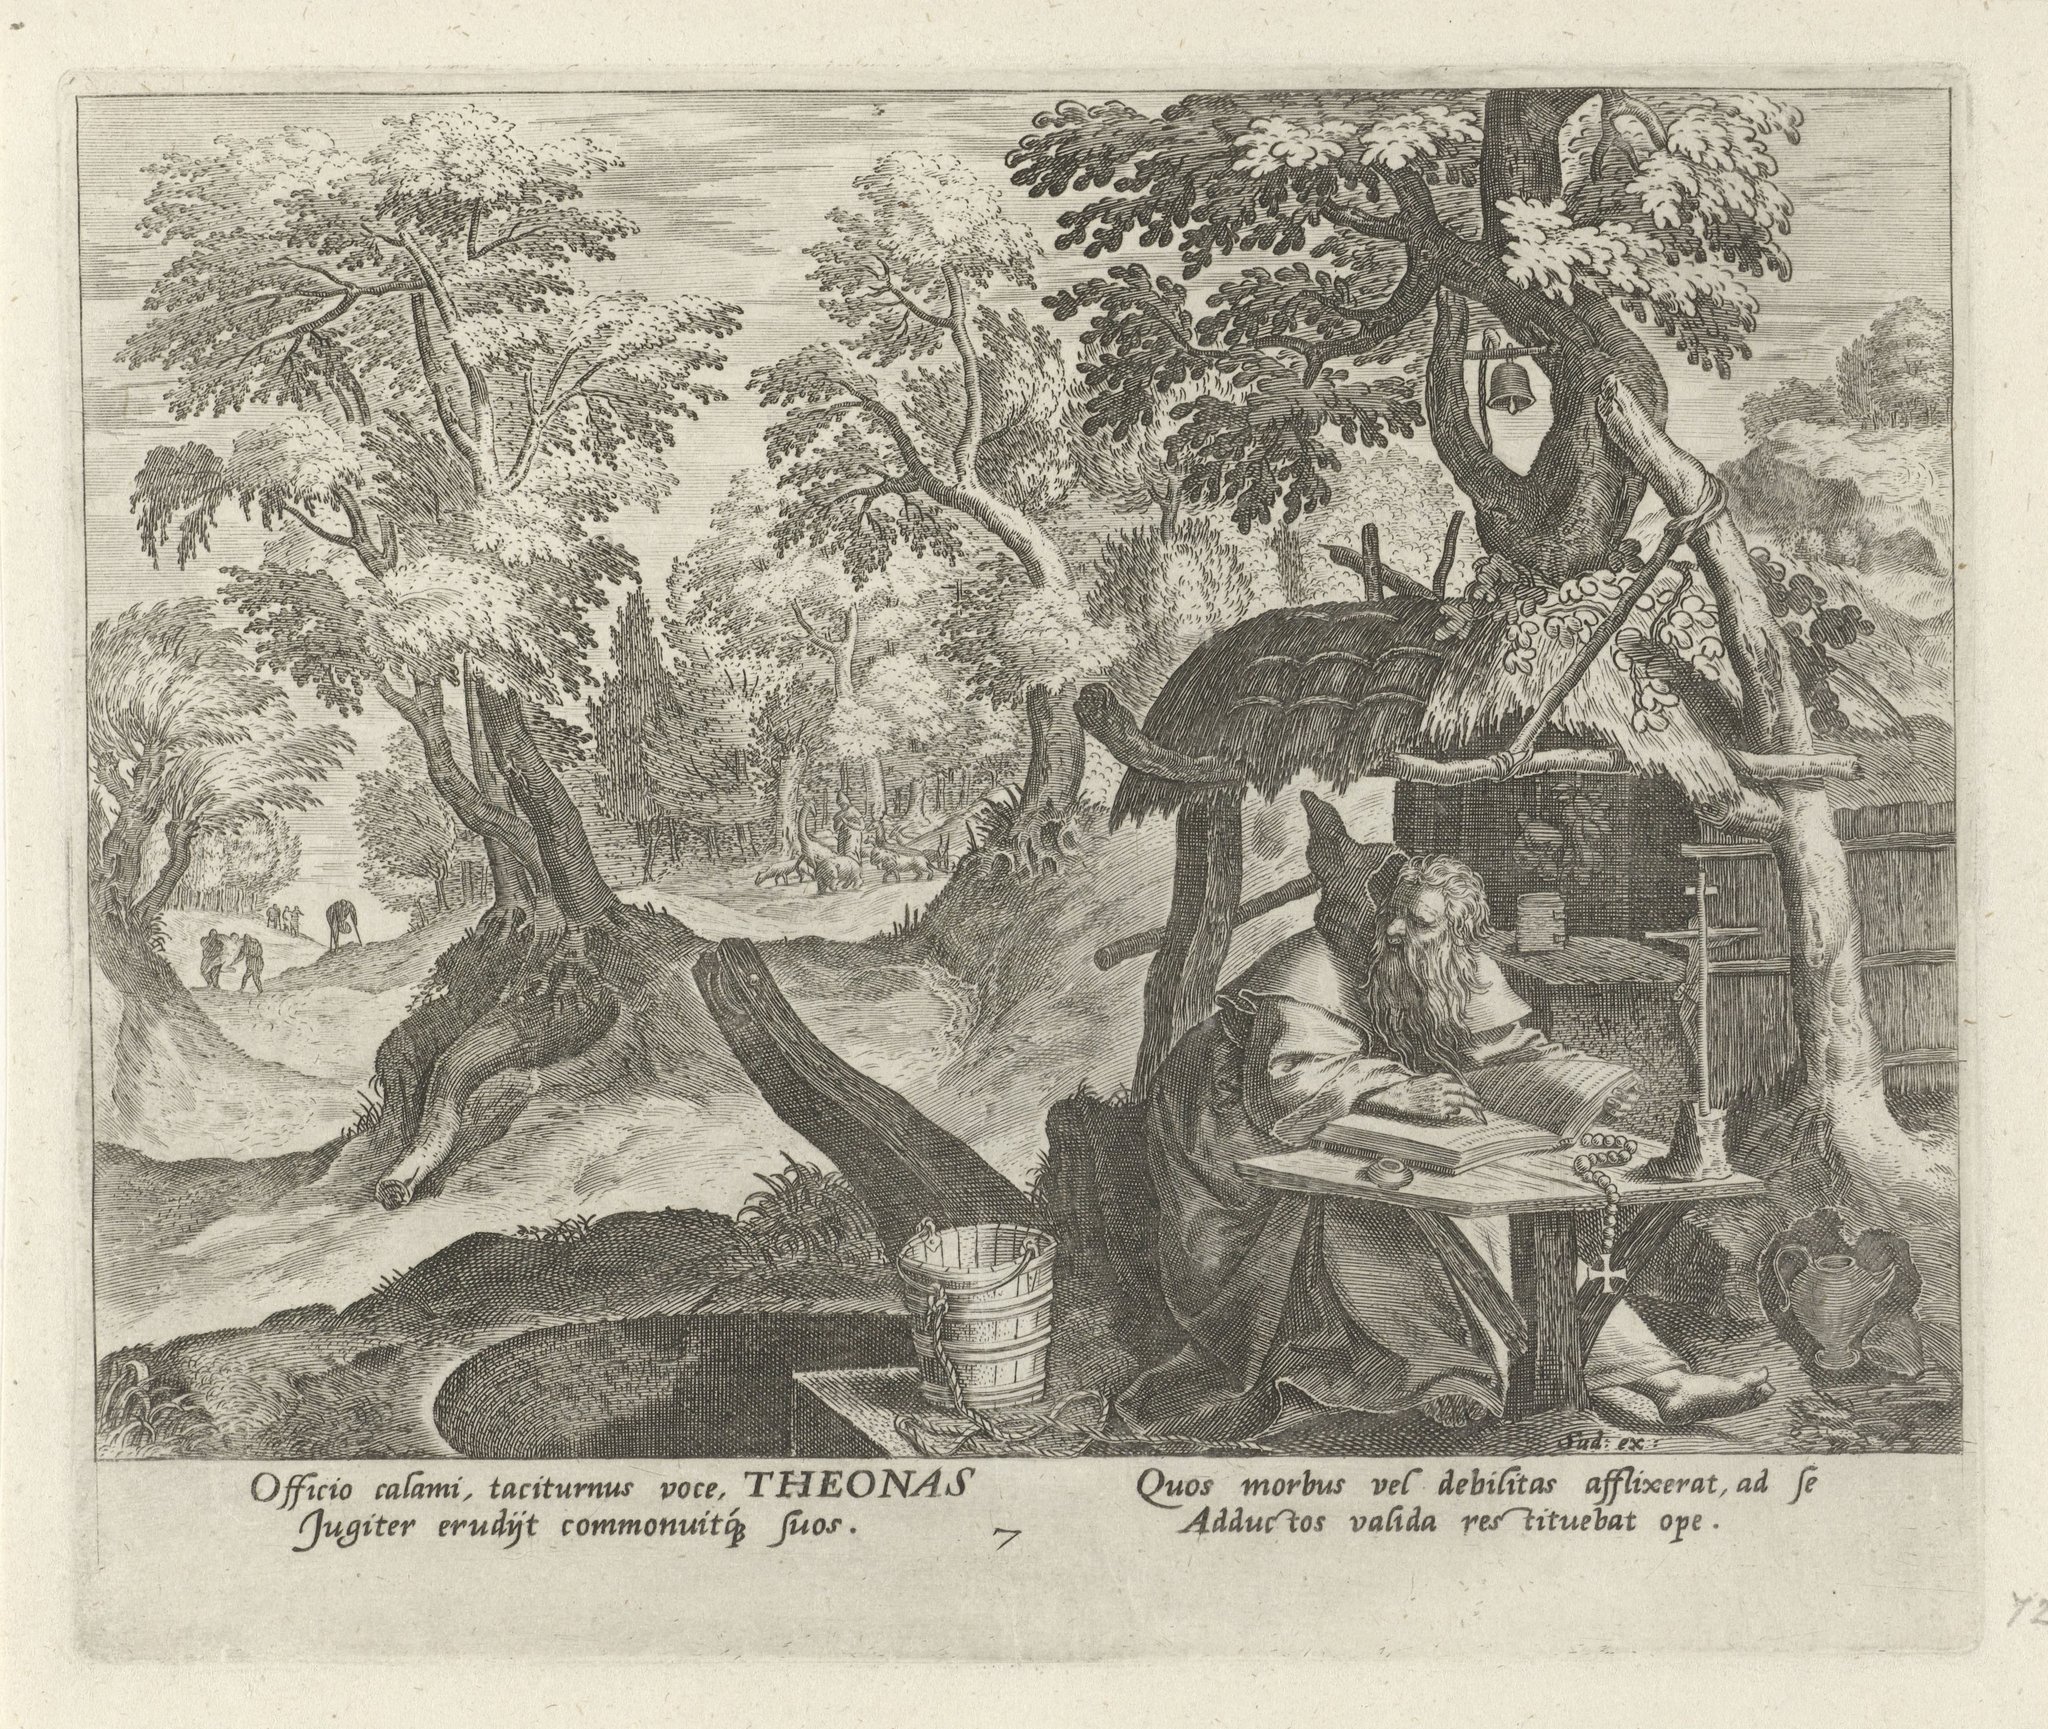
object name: print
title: Theonas als kluizenaar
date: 1583-1588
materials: paper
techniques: engraving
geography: antwerp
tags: male saints (with name), anchorite, hermit, cave, grotto, beggar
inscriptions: collector's mark: Lugt 2228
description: H. Theonas als kluizenaar in een grot in de wildernis. Hij zit voor een werktafel en leest een bijbel. Een landschap met bedelaars op de achtergrond.